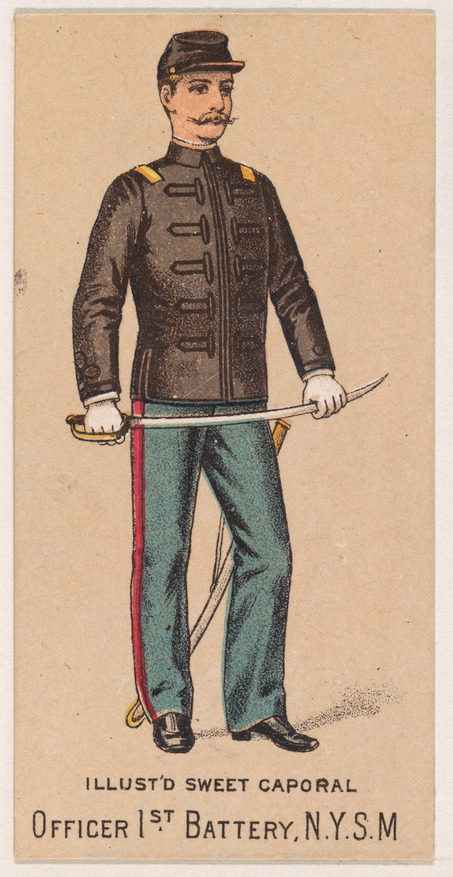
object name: print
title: Officer, 1st Battery, New York State Militia, from the Military Series (N224) issued by Kinney Tobacco Company to promote Sweet Caporal Cigarettes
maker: kinney brothers tobacco company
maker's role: publisher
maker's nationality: american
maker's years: 1869-2011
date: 1888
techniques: color lithograph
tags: military,men